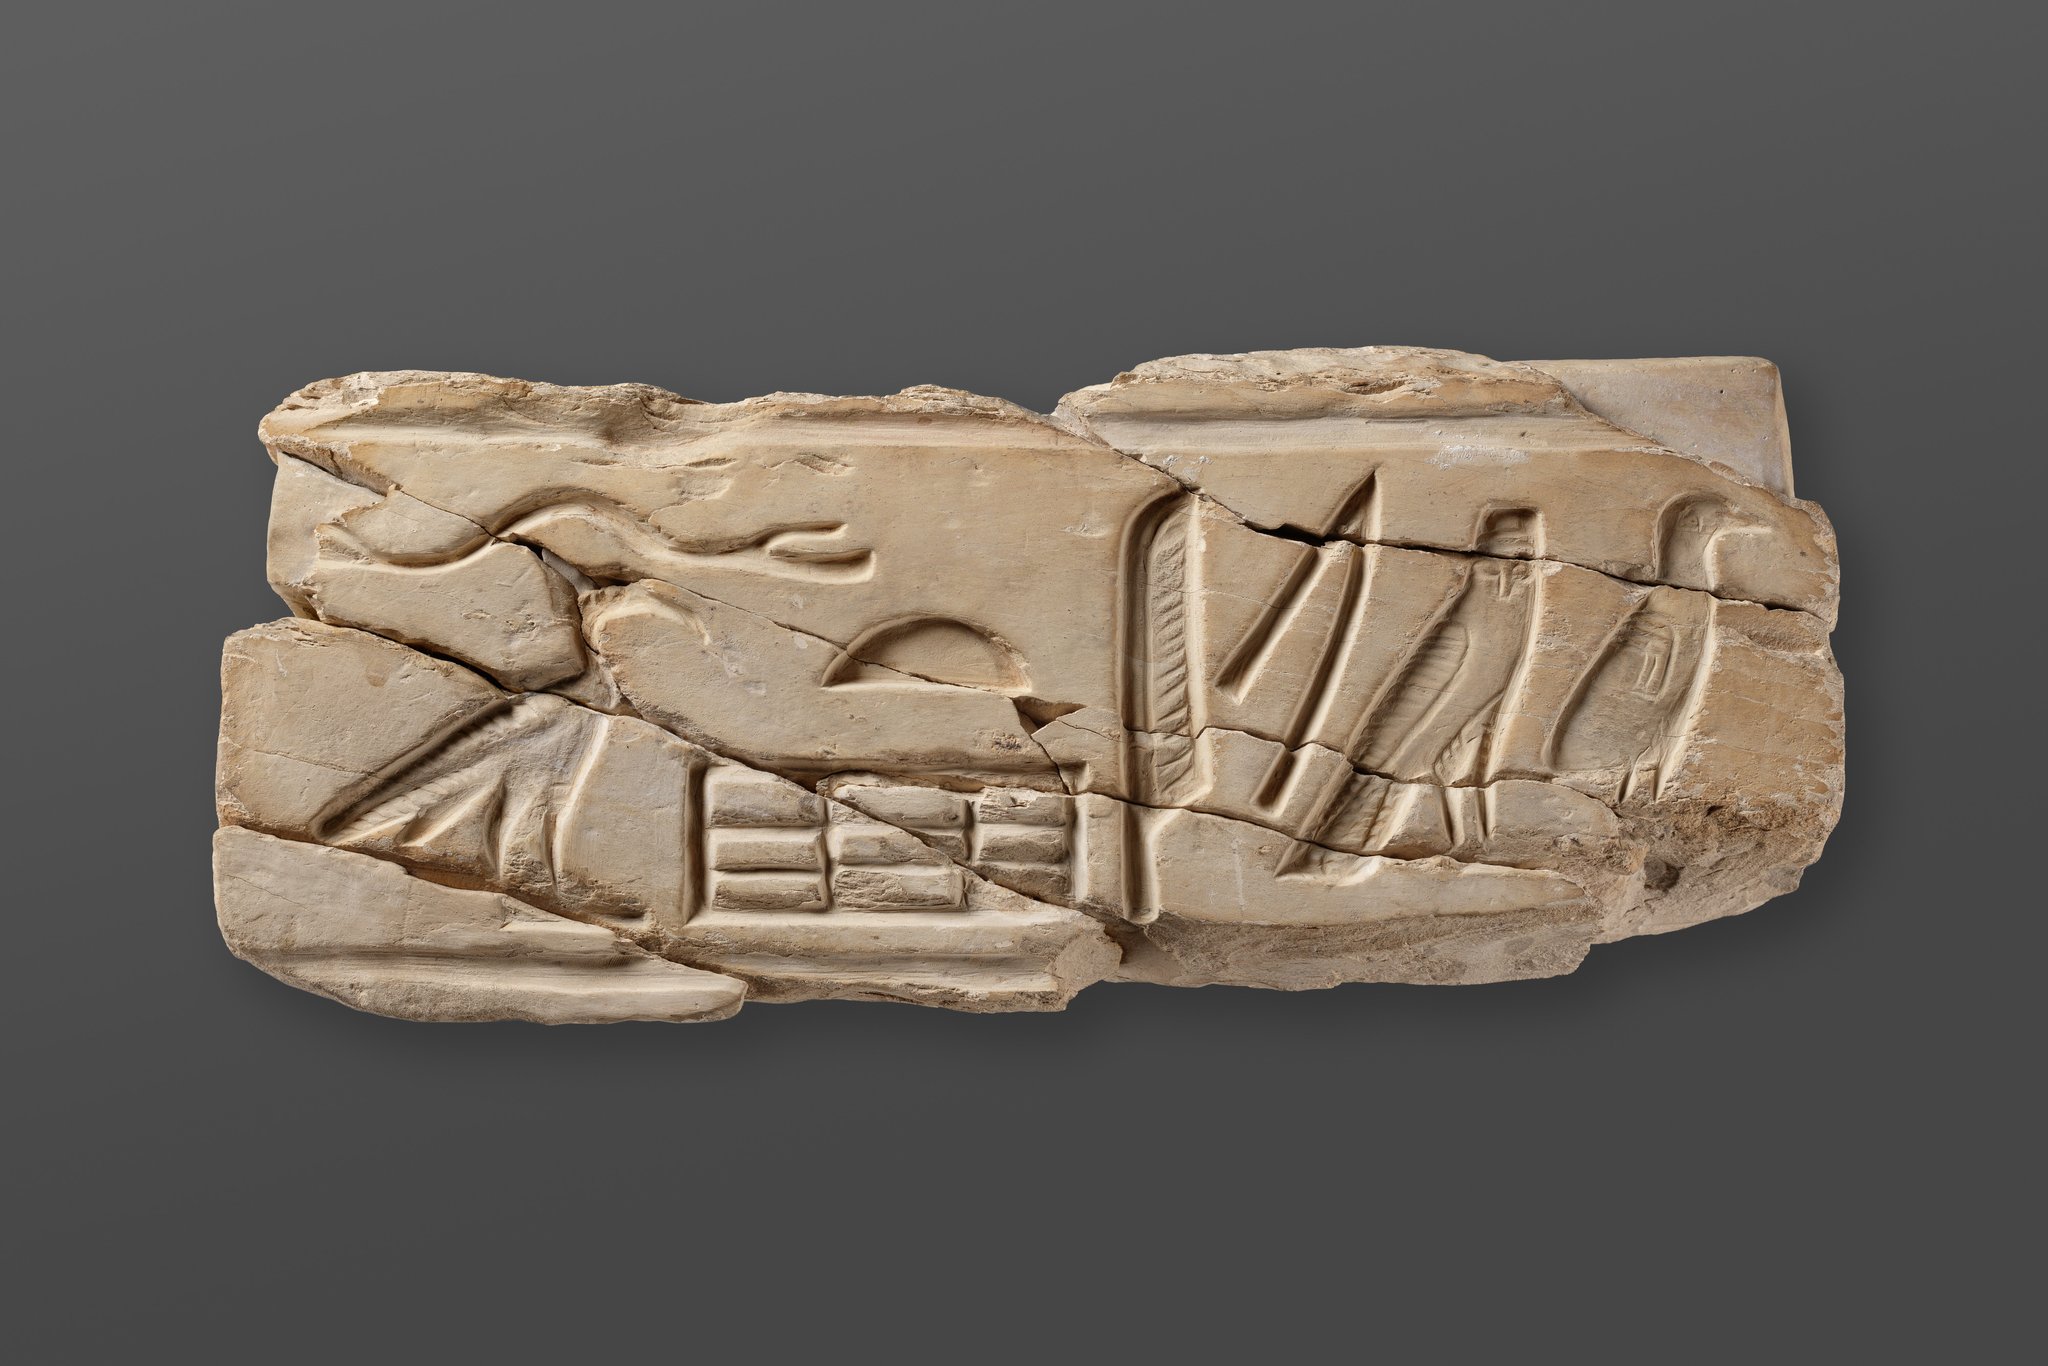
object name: relief fragment, tomb of mereri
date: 2100-2030 BCE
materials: limestone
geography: egypt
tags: birds